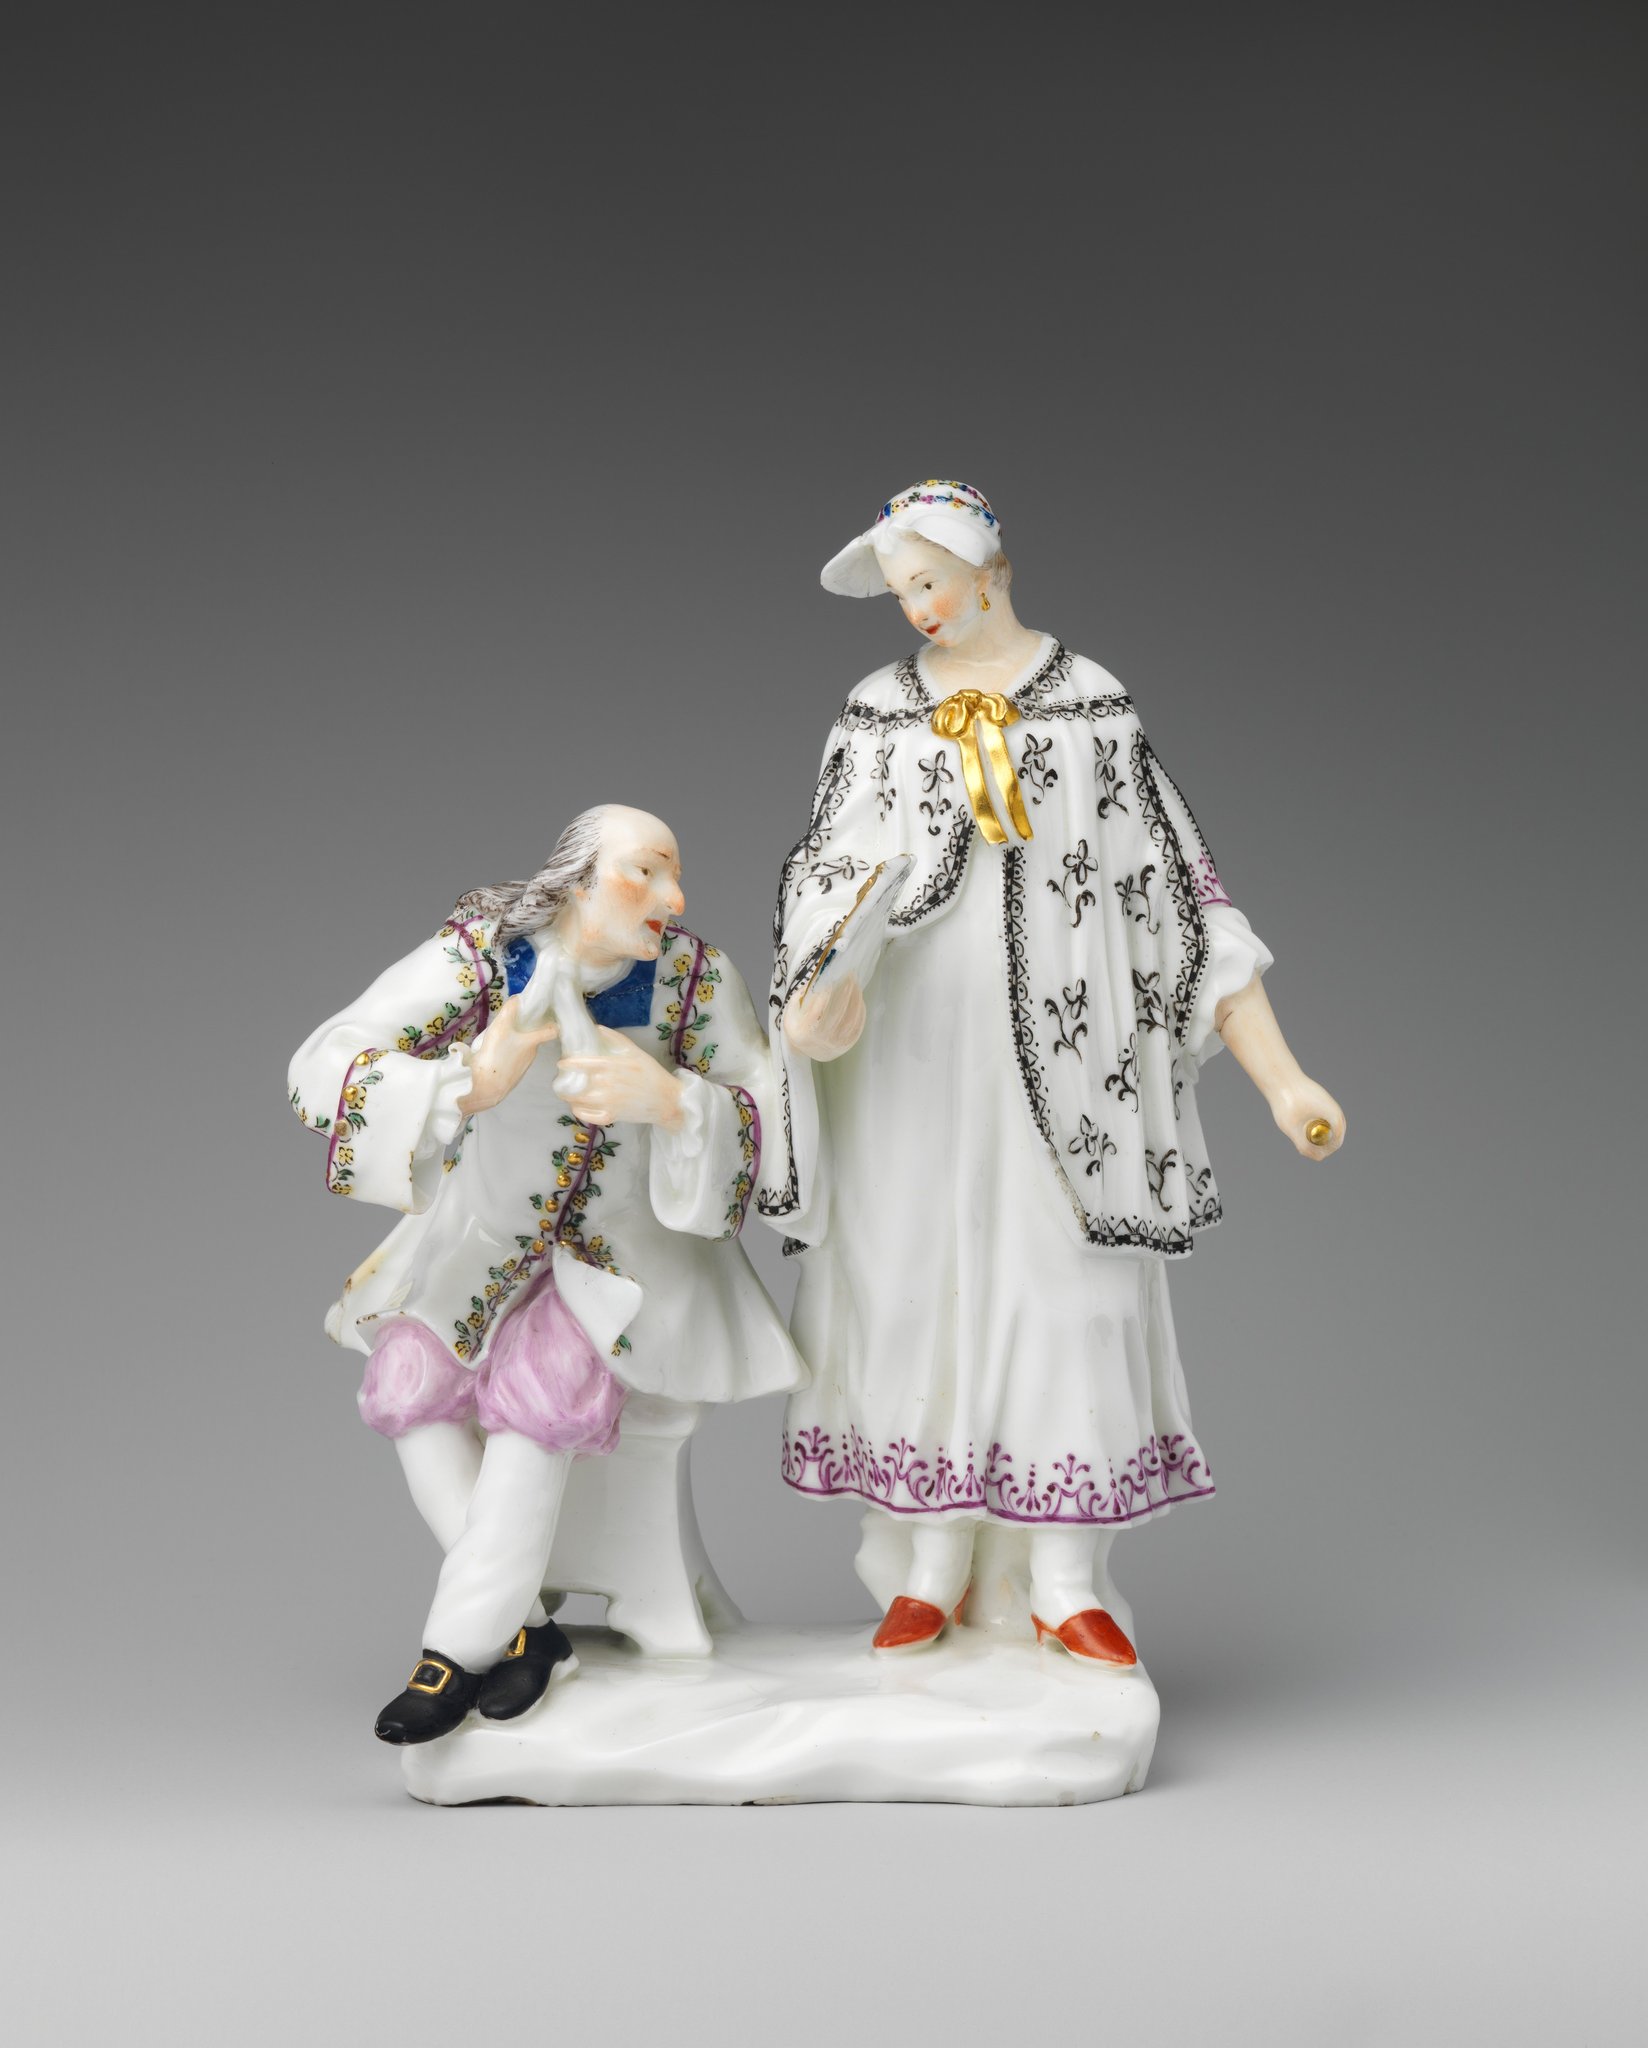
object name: figure group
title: The Cravat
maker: capodimonte porcelain manufactory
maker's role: manufactory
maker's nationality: italian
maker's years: 1740-1759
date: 1750-1755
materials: soft paste porcelain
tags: men,women